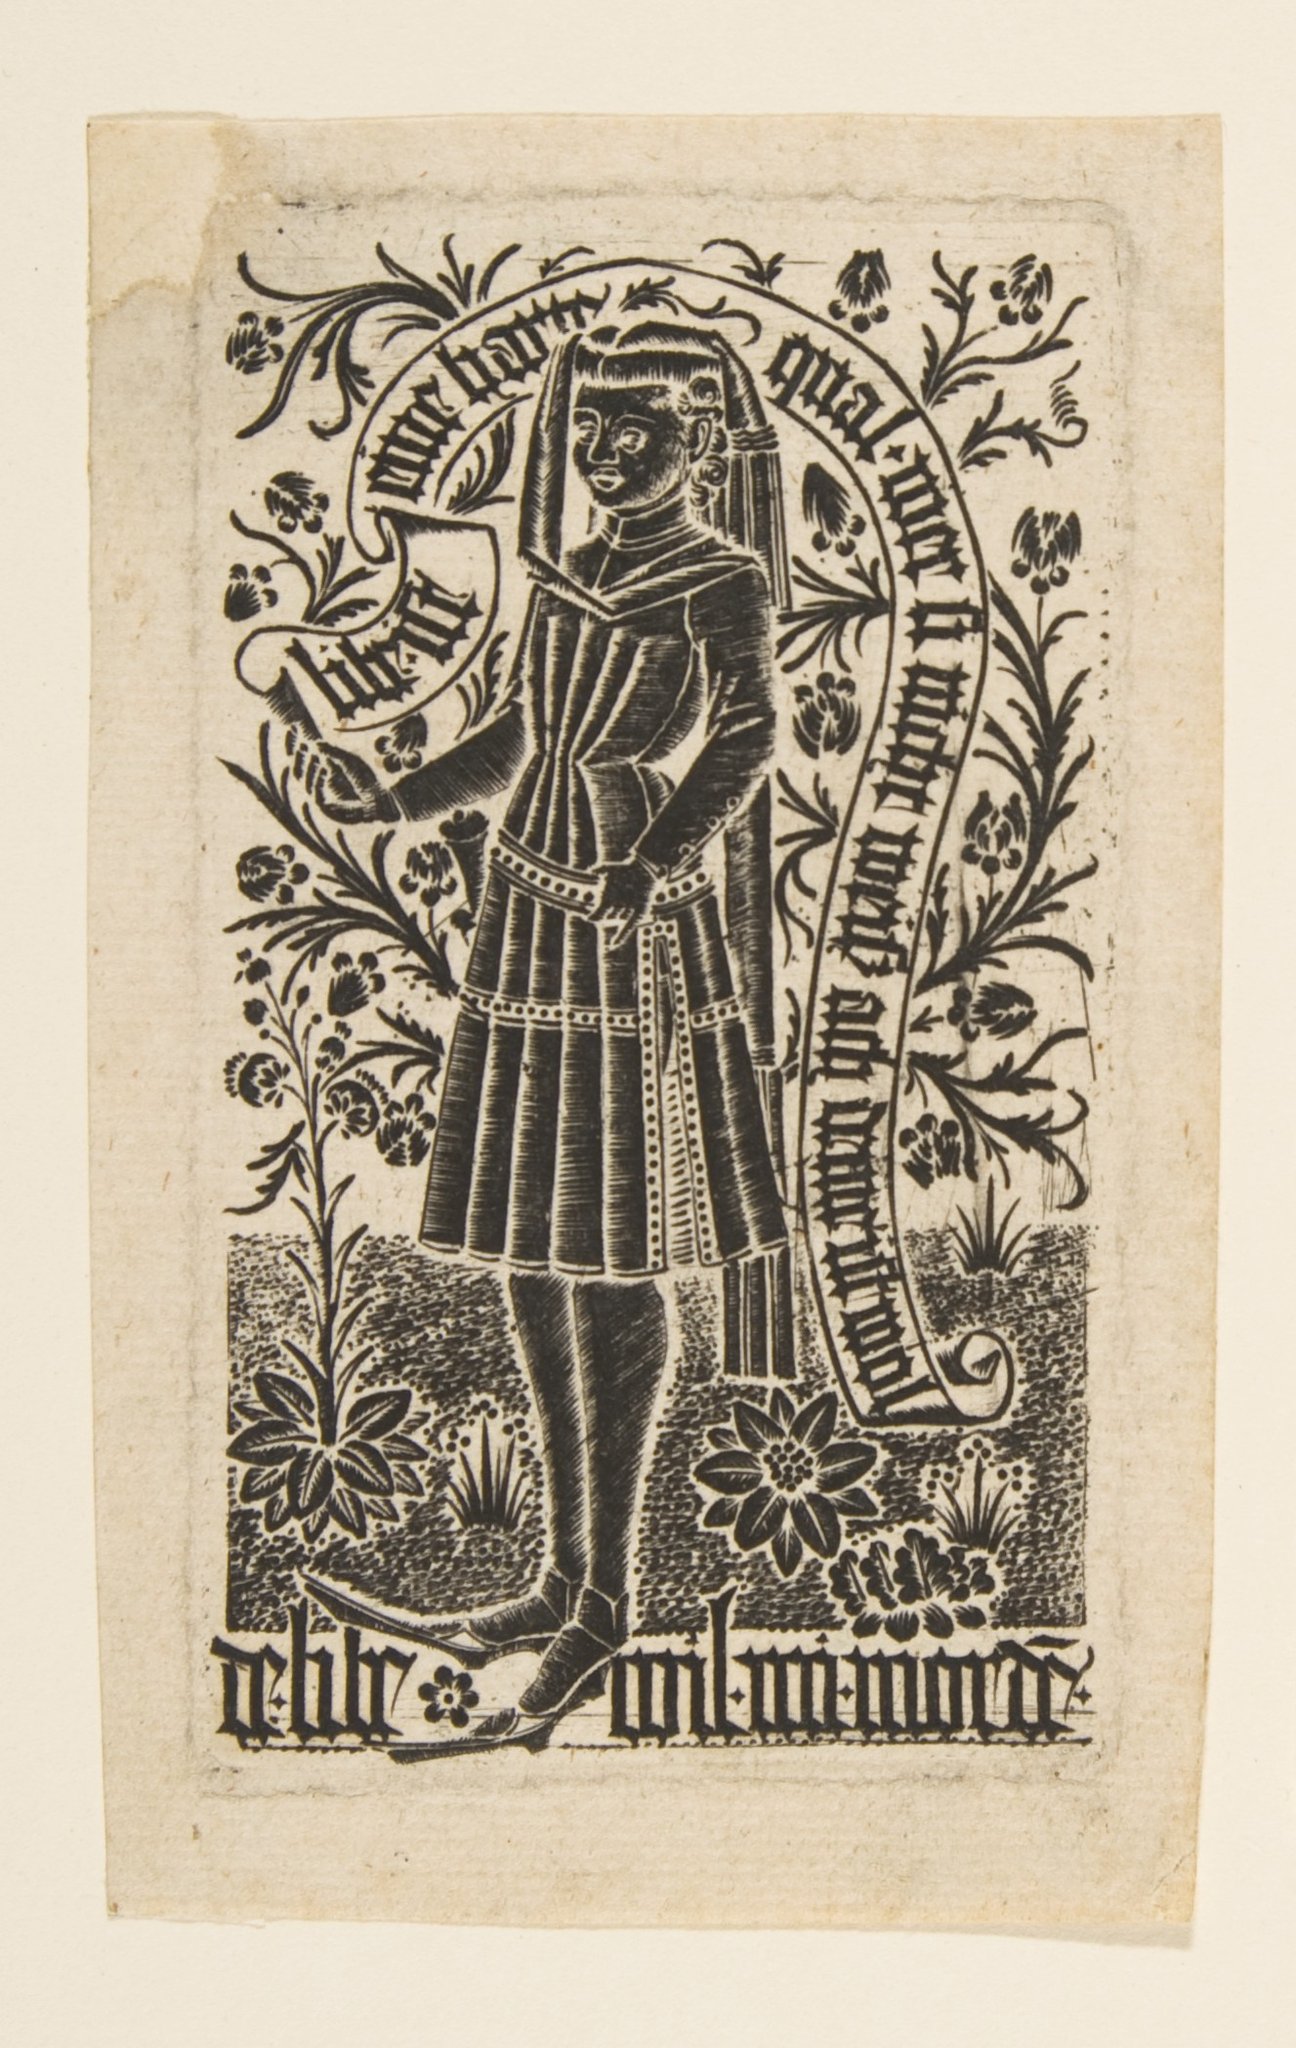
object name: print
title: L'Amoureux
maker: anonymous, german, 15th century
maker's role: artist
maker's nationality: german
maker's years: 1400-1500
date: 1401-1500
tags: lovers,women